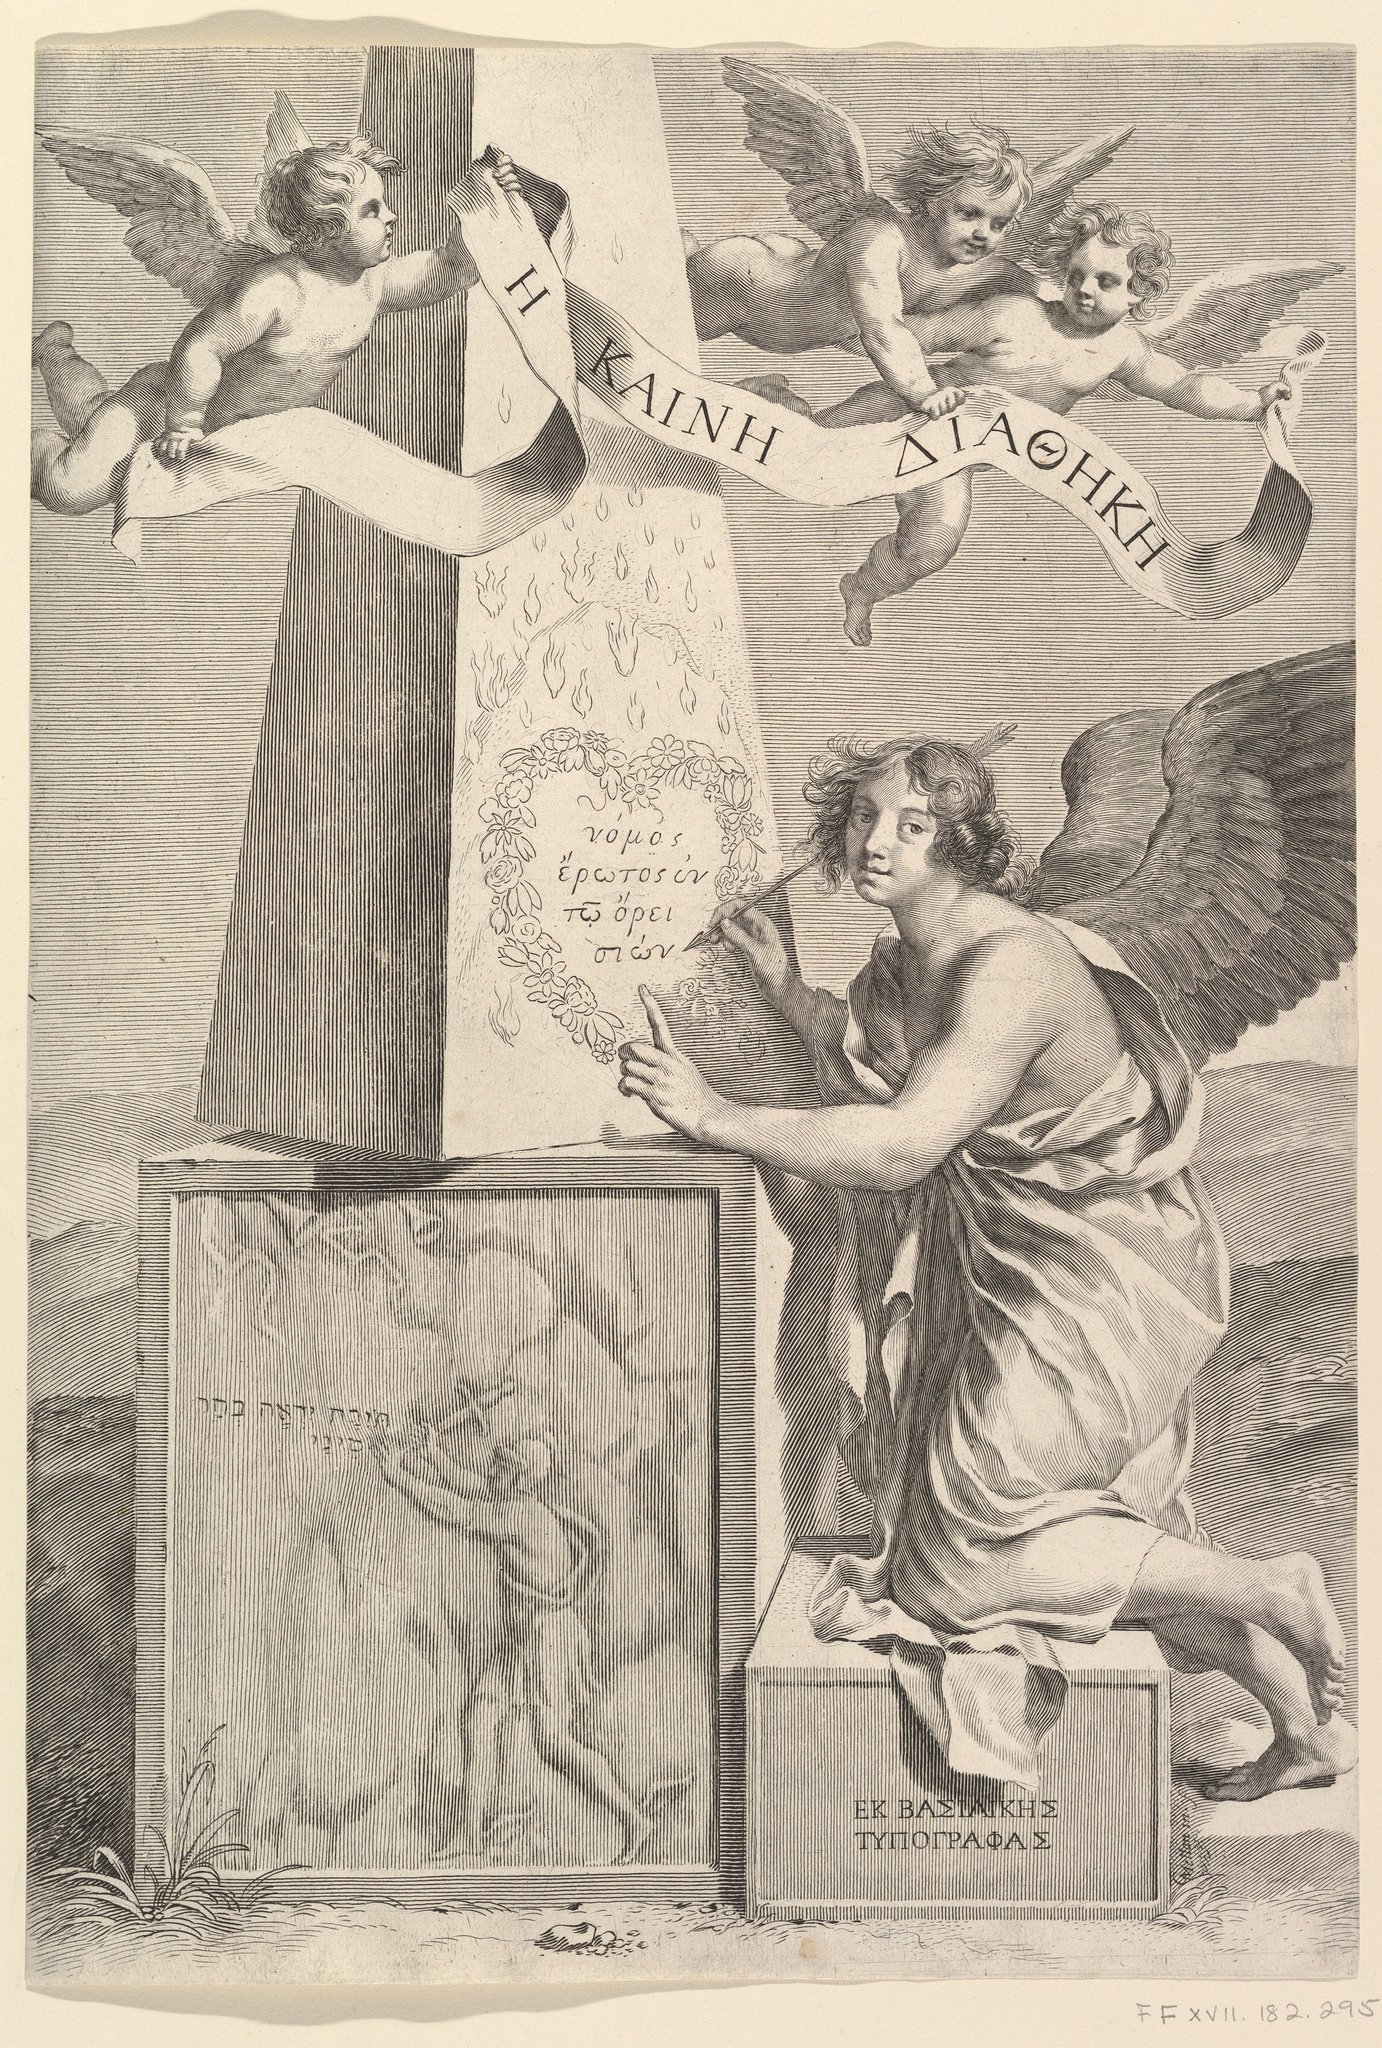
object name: print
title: Frontispiece for New Testament in Greek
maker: claude mellan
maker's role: artist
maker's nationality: french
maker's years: 1598-1688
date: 1642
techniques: engraving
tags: obelisks,angels,writing